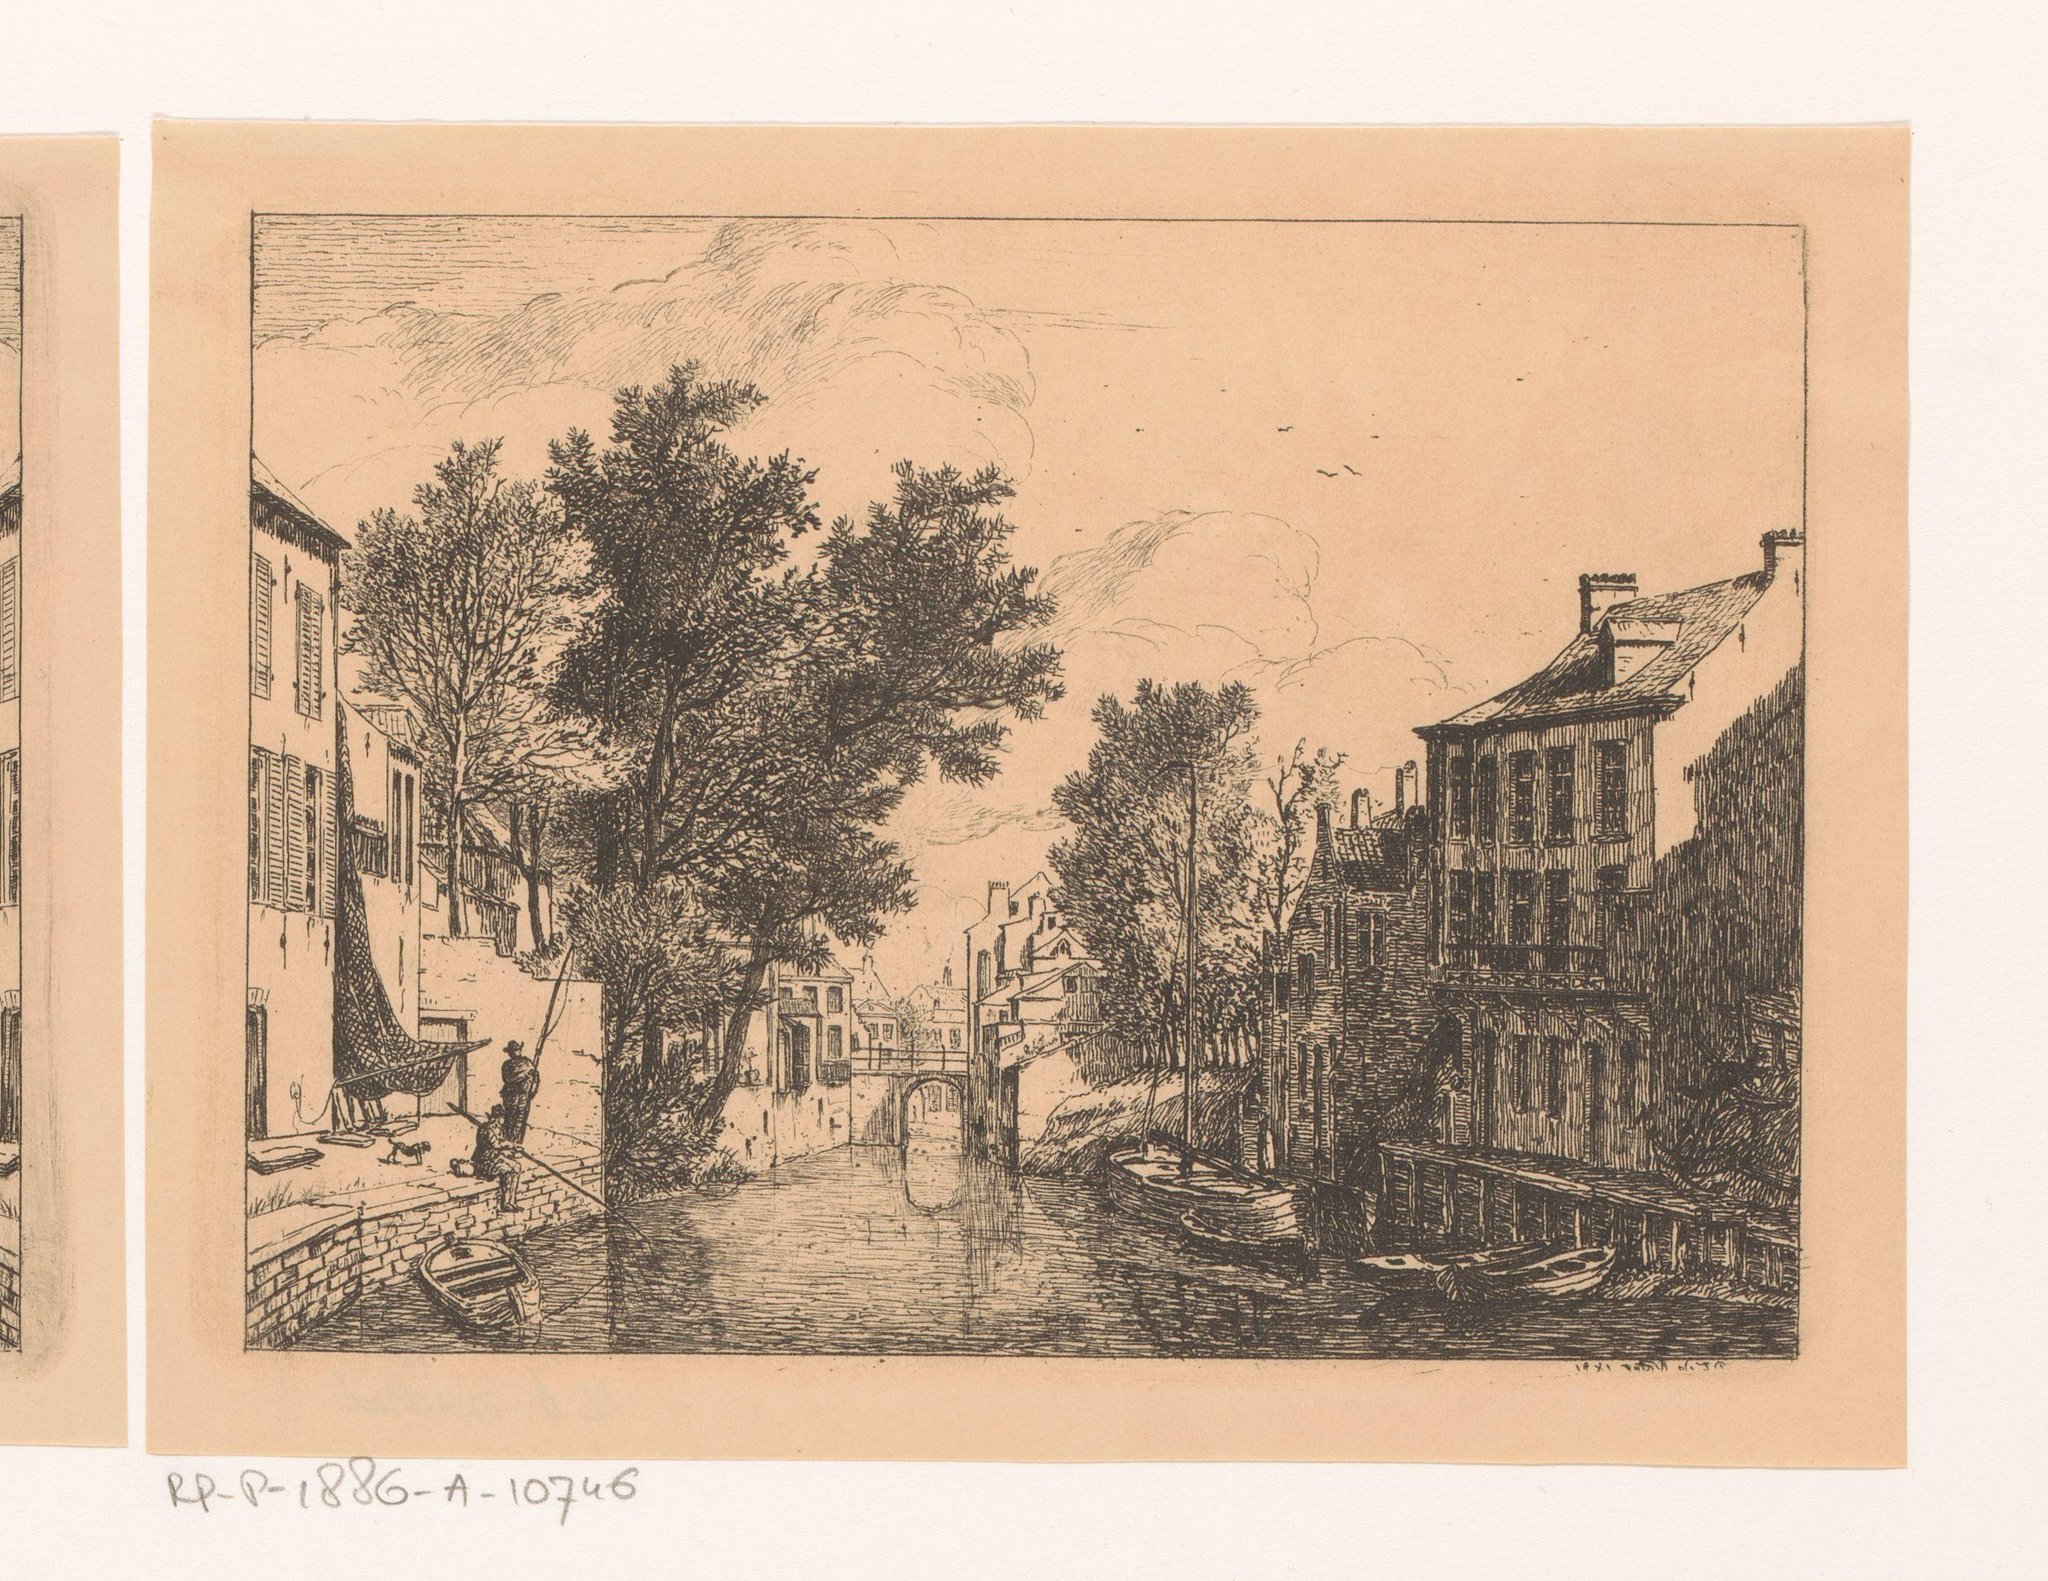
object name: print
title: Recueil de gravures à l'eau forte, dont plusieurs d'apres Hobbema, par P.F. de Noter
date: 1831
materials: paper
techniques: printmaking, etching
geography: ghent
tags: bridge in city across river, canal, etc., angling, ghent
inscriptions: collector's mark: Lugt 2228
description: In de inventaris staat vermeld dat het gaat om de 'Waalsche brug'.